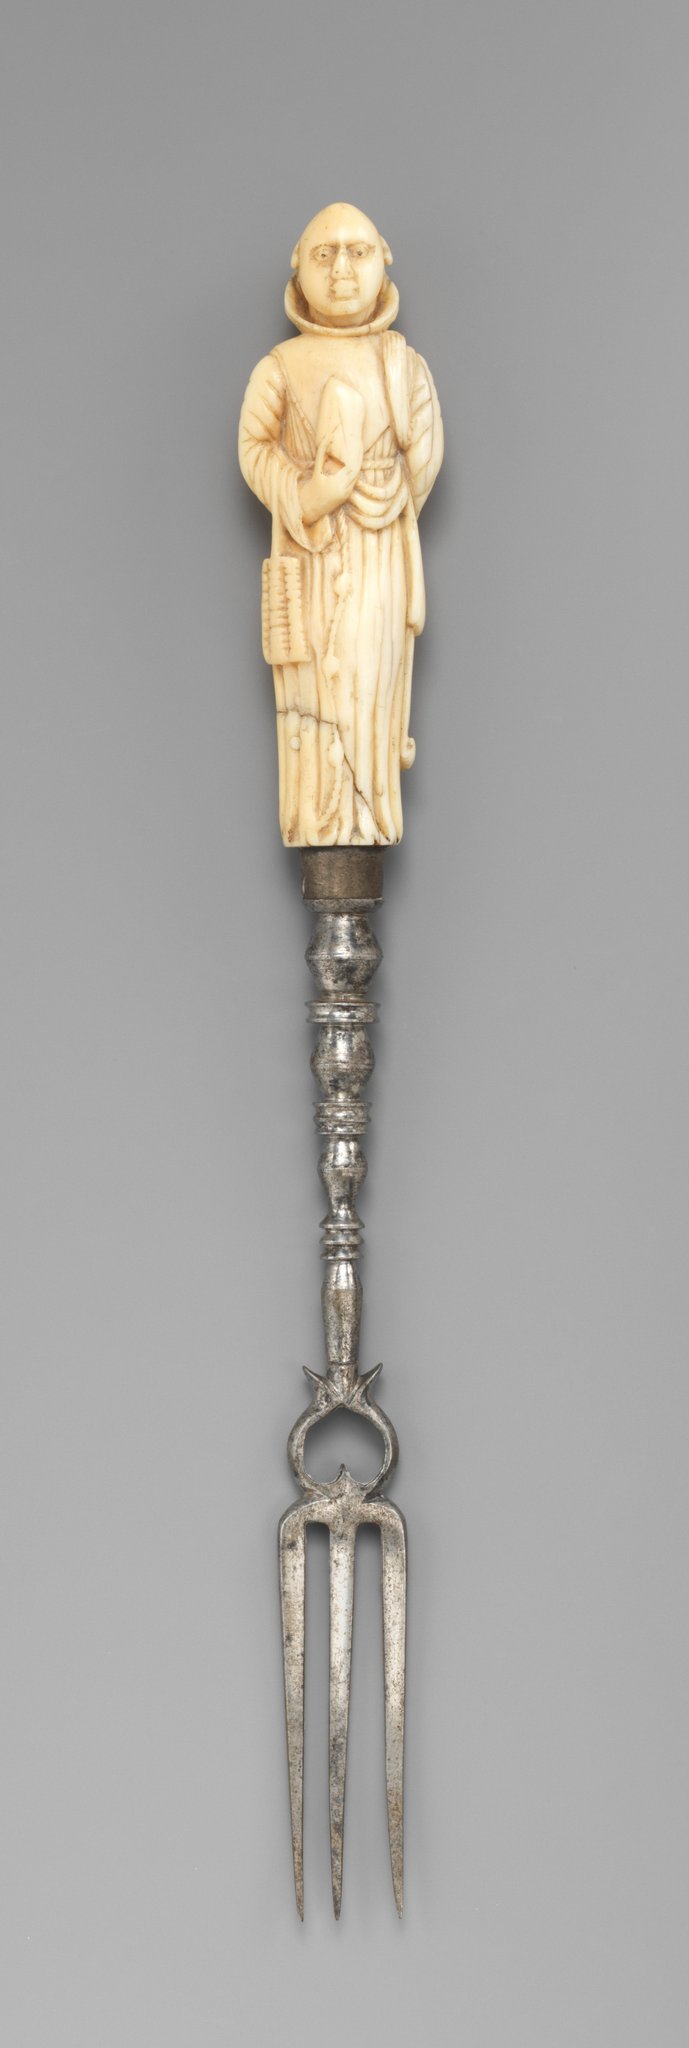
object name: table fork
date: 1601-1700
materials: ivory, steel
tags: men